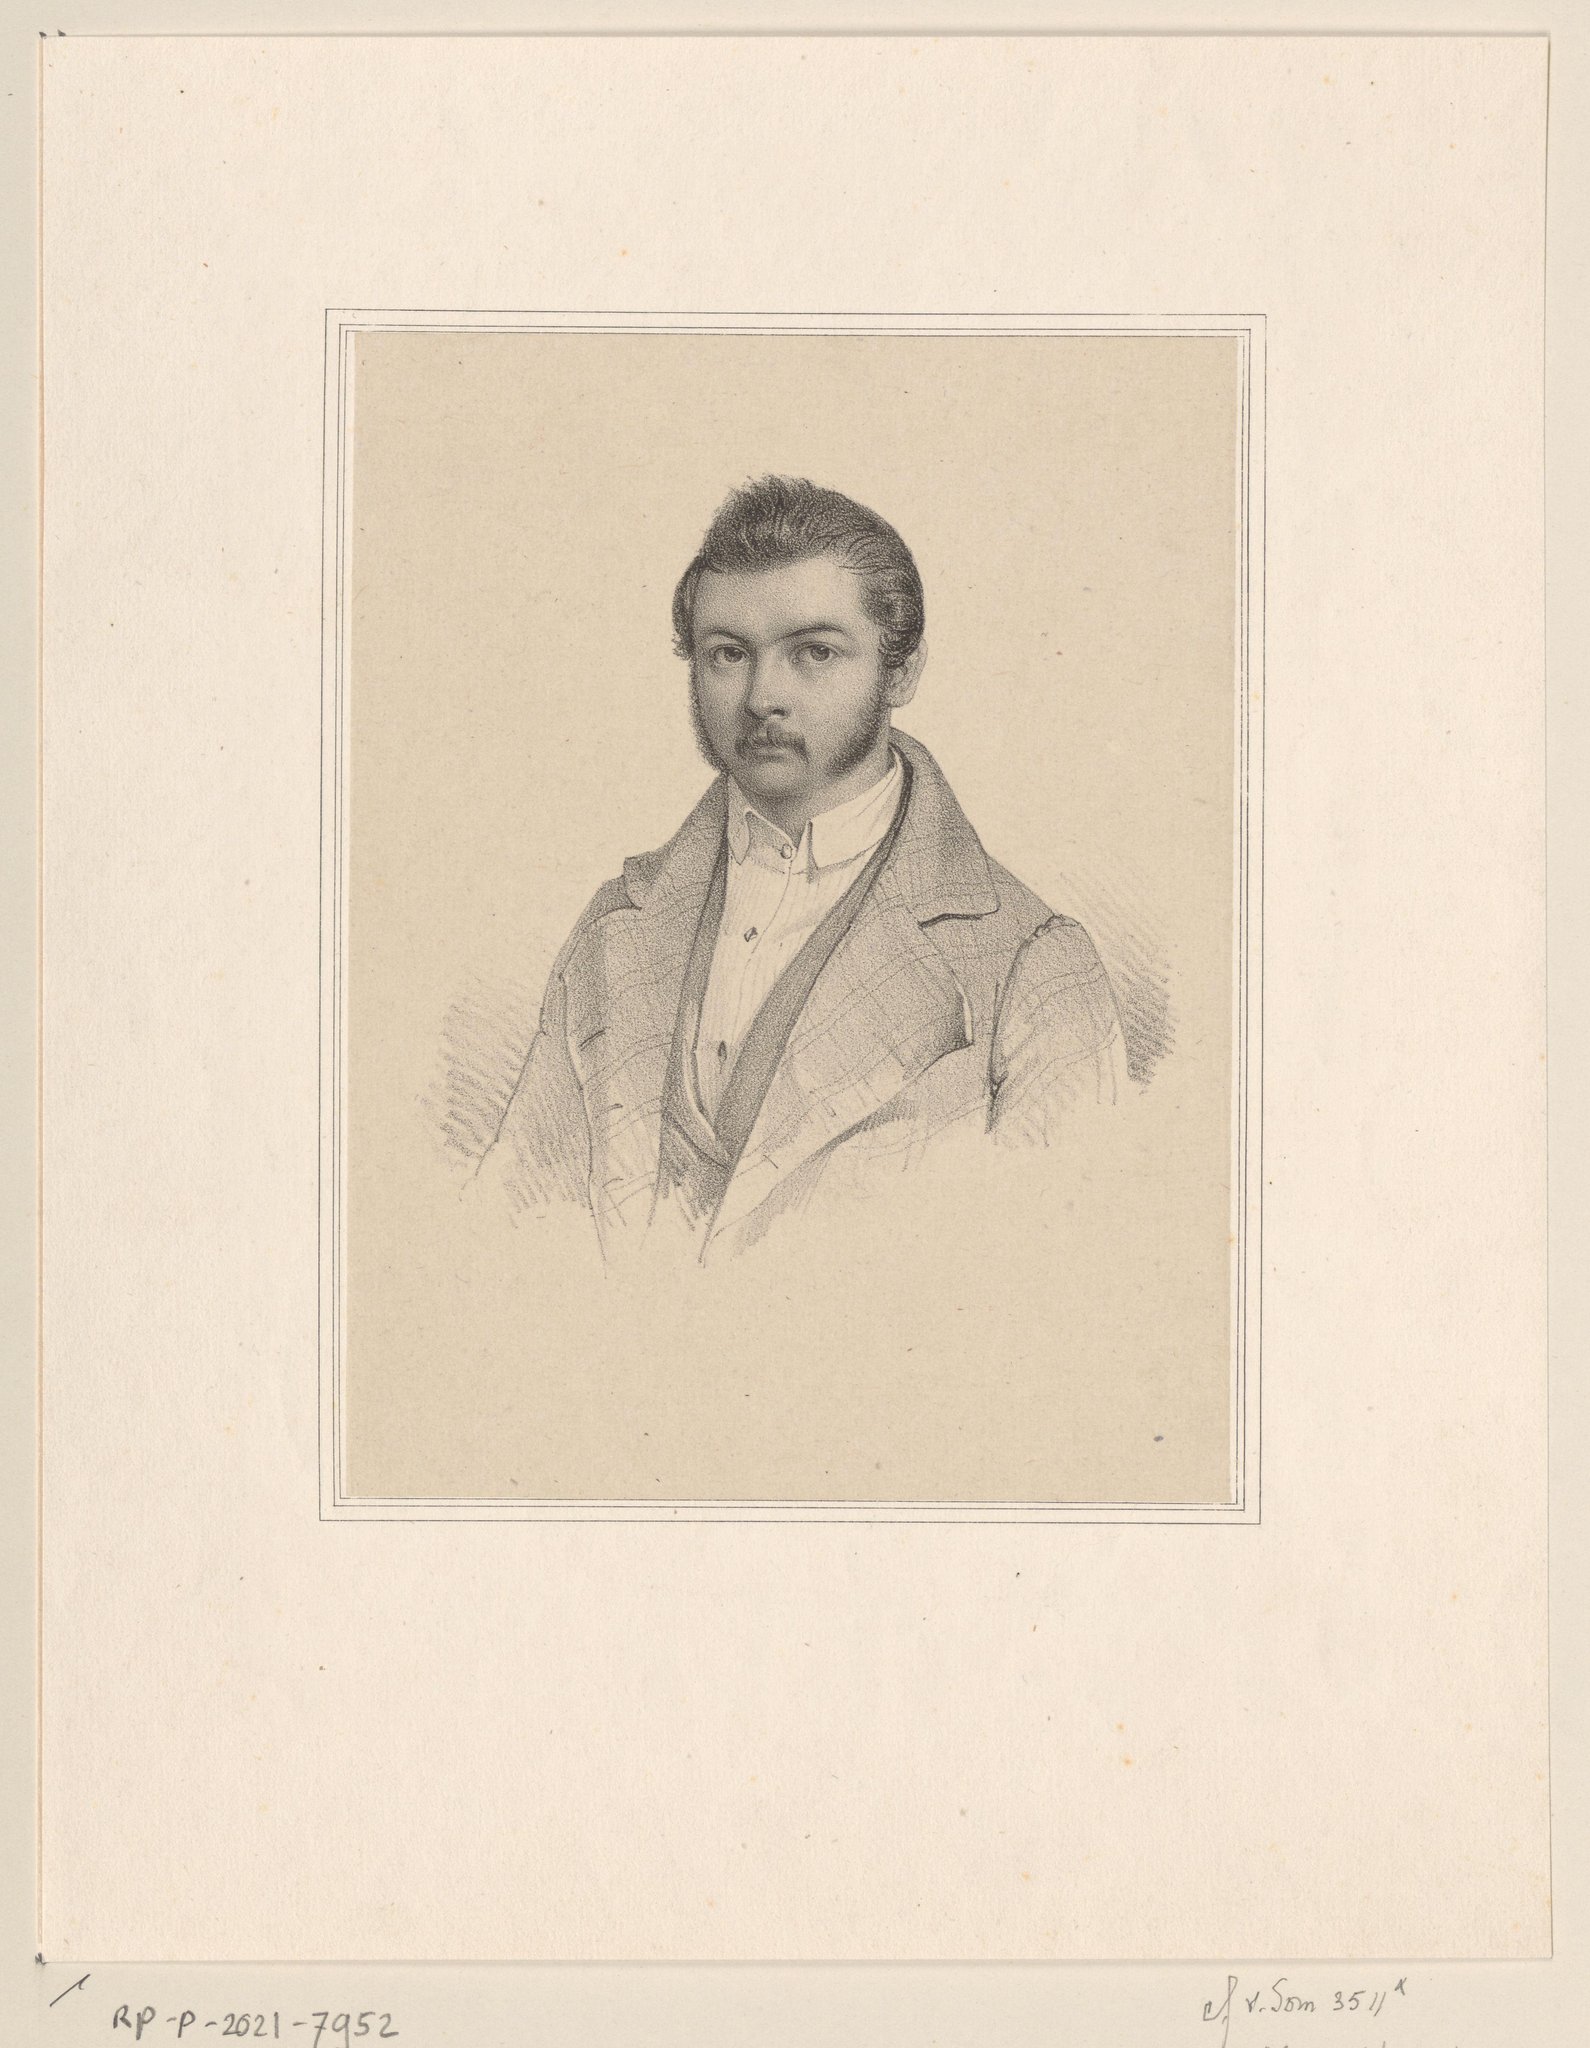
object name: print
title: Portret van een man, mogelijk Henri Martin (1793-1882)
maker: Anonymous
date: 1810-1899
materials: paper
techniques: lithograph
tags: rotterdam, historical persons